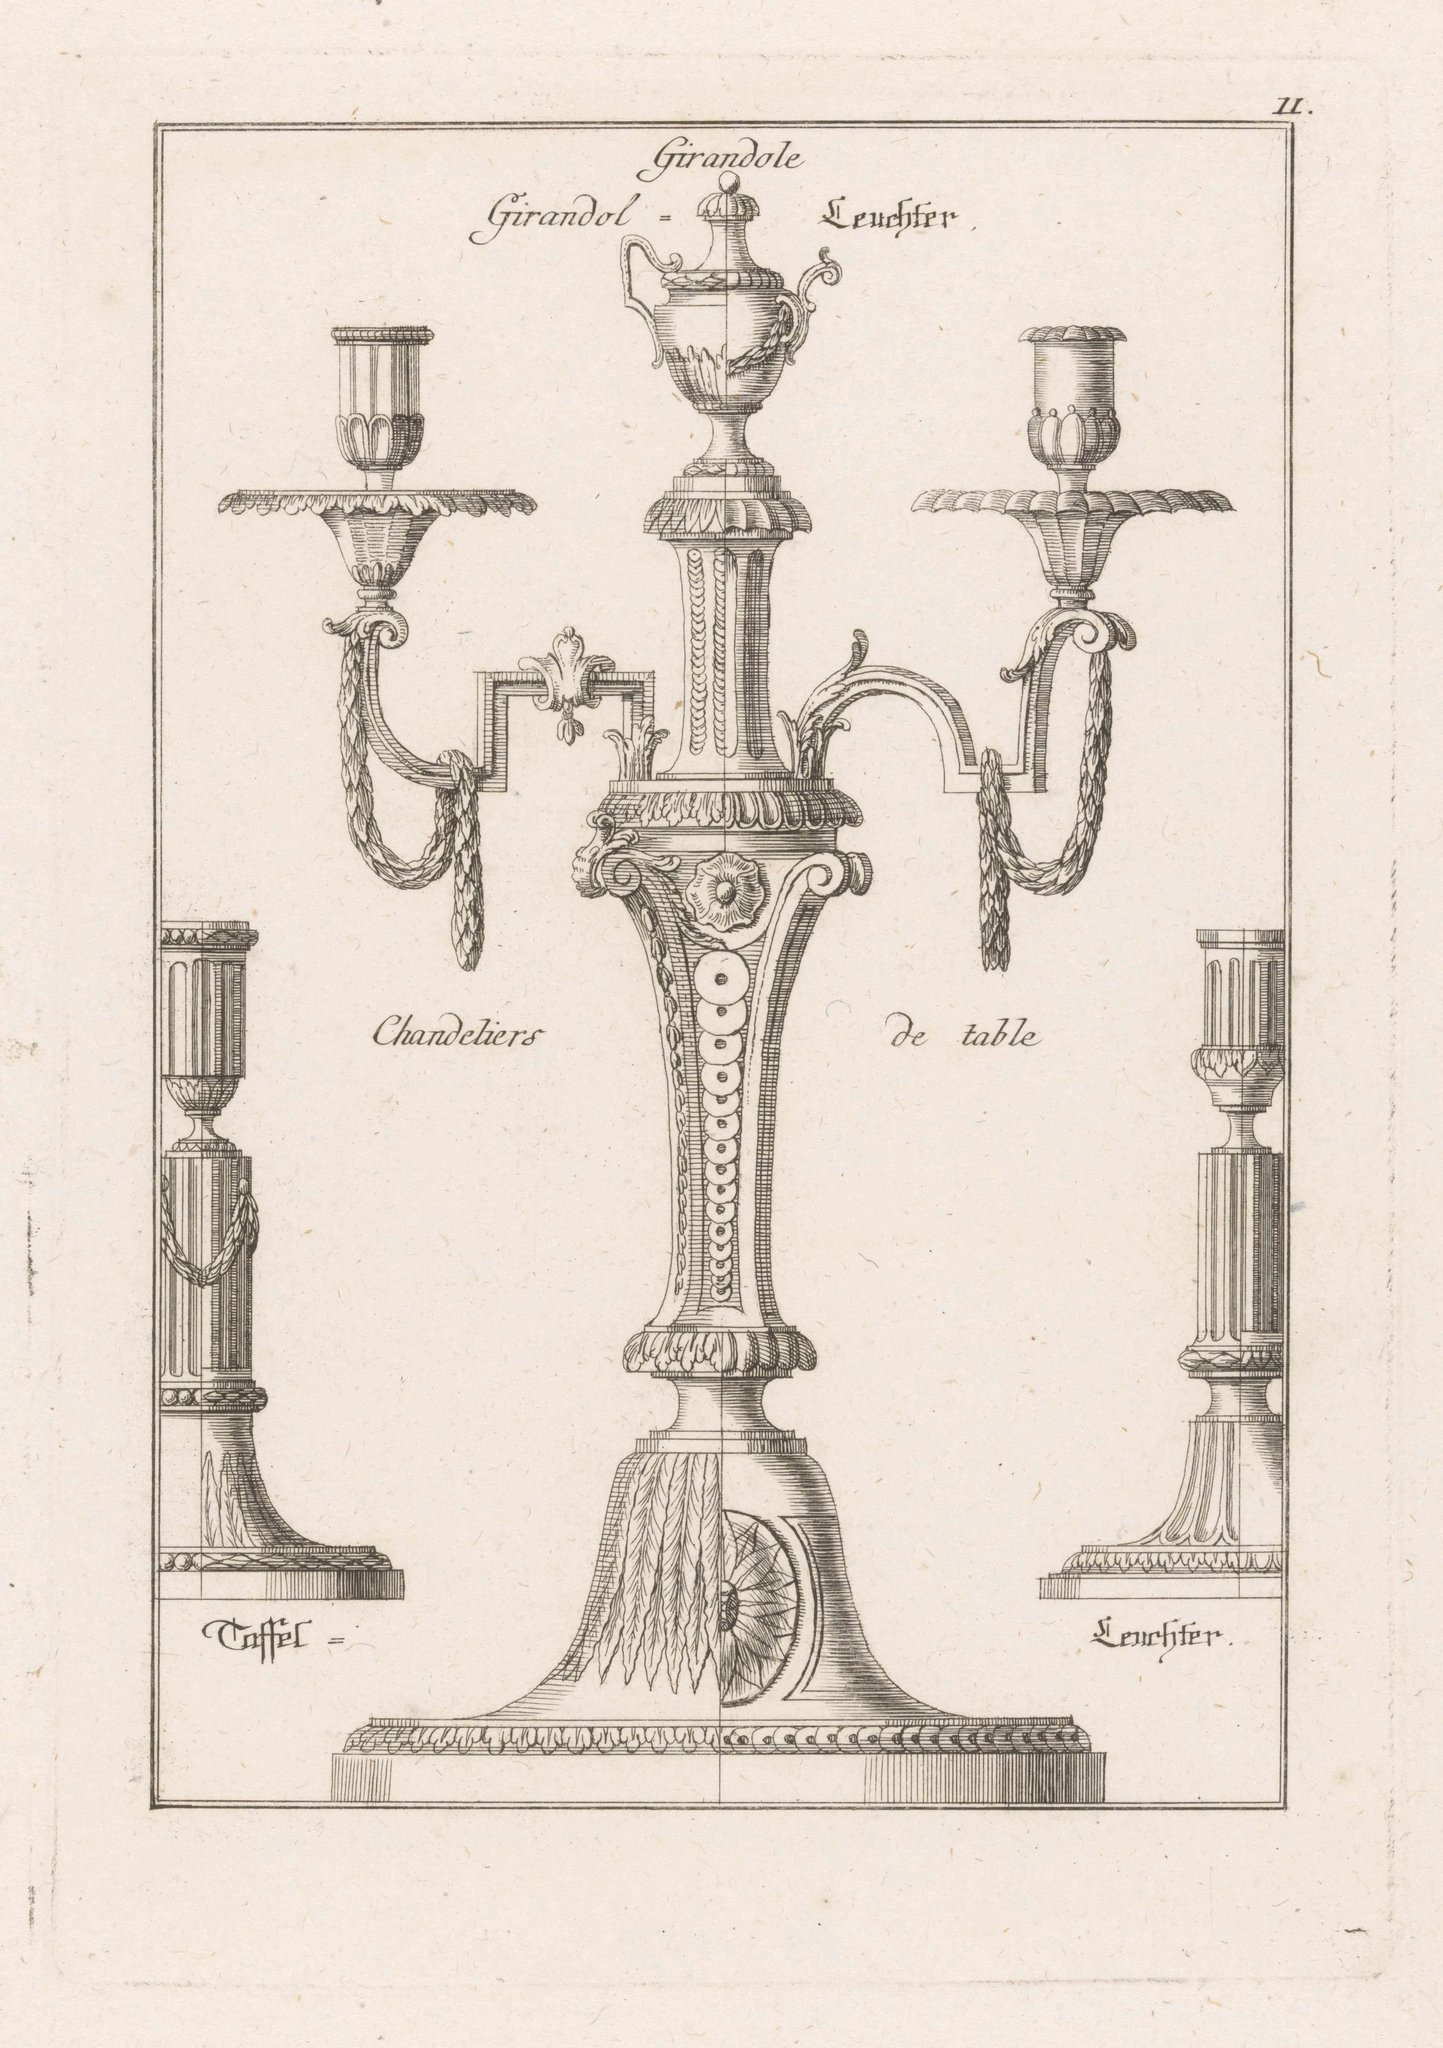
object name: print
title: Desseins de diverses pièces d'argenterie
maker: franz xaver habermann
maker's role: draughtsman, print maker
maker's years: 1721-1796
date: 1731-1796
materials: paper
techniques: etching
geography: germany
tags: chandelier, candelabrum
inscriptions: collector's mark: Lugt 2760, collector's mark: Lugt 2228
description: Twee tafelkandelaars en een driearmige girandole, met bladmotieven en ornamenten.